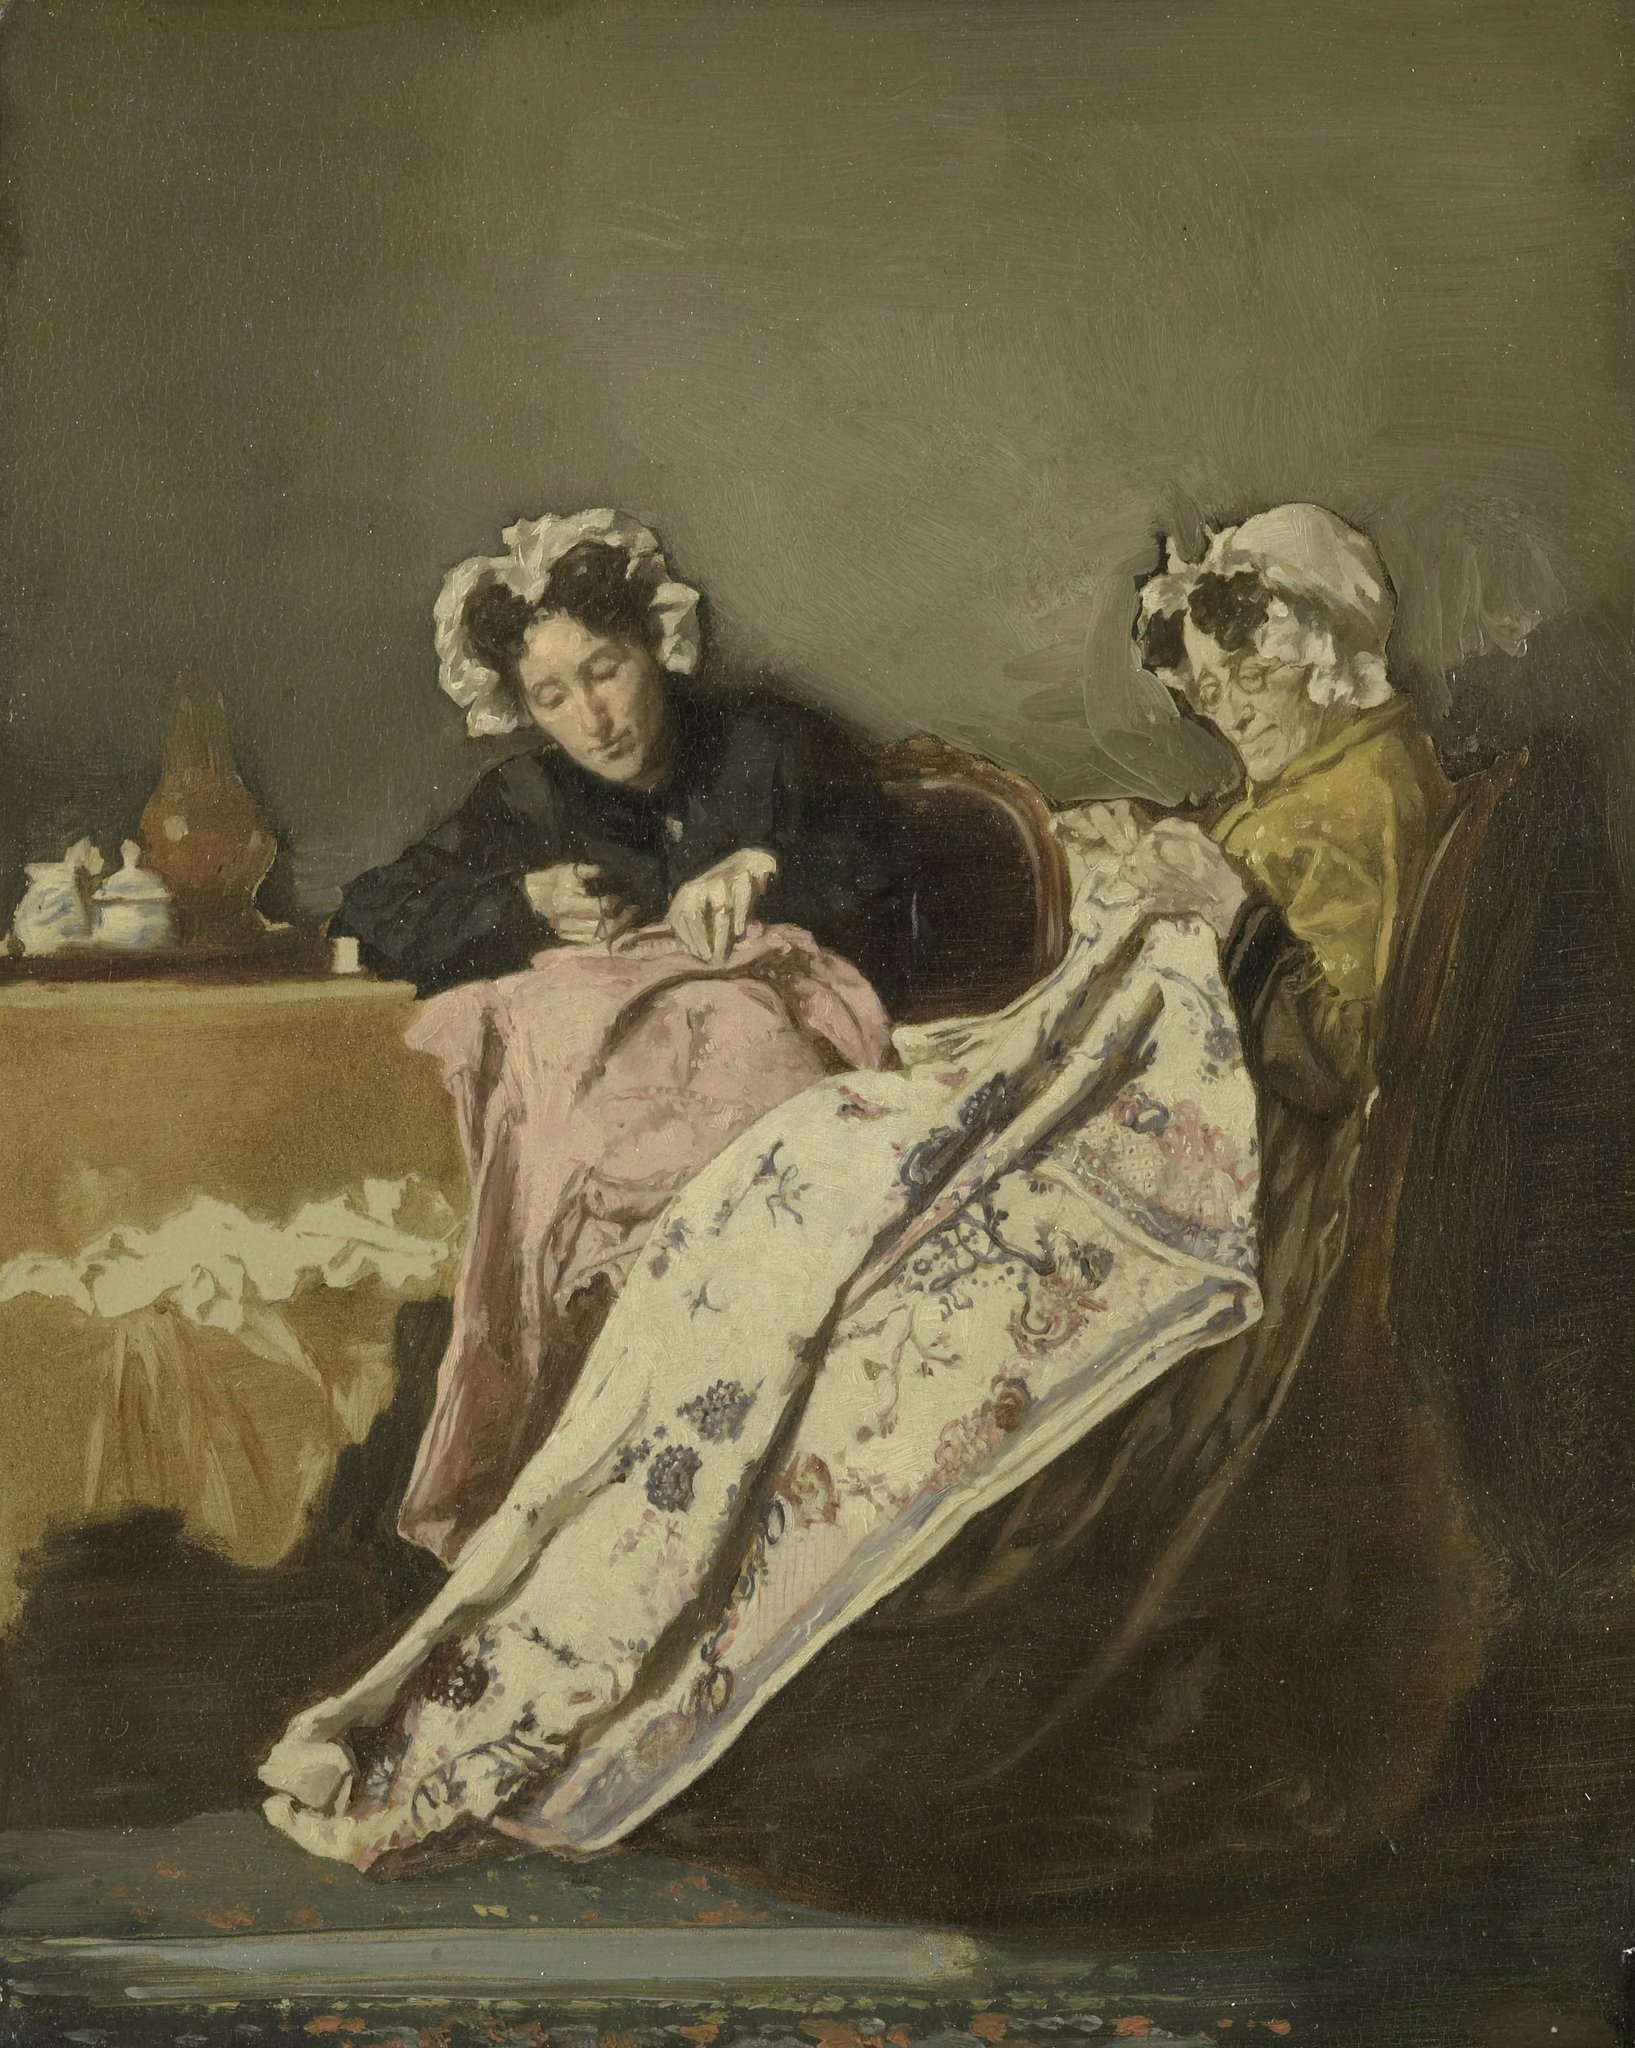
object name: painting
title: Two Ladies at their Sewing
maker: alexander hugo bakker korff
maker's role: draughtsman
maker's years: 1824-1882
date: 1860-1882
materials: oil, panel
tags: (other forms of) needlework, e.g.: crocheting, knitting, embroidering, sewing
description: Interieur waarin twee dames aan een tafel zitten te handwerken.